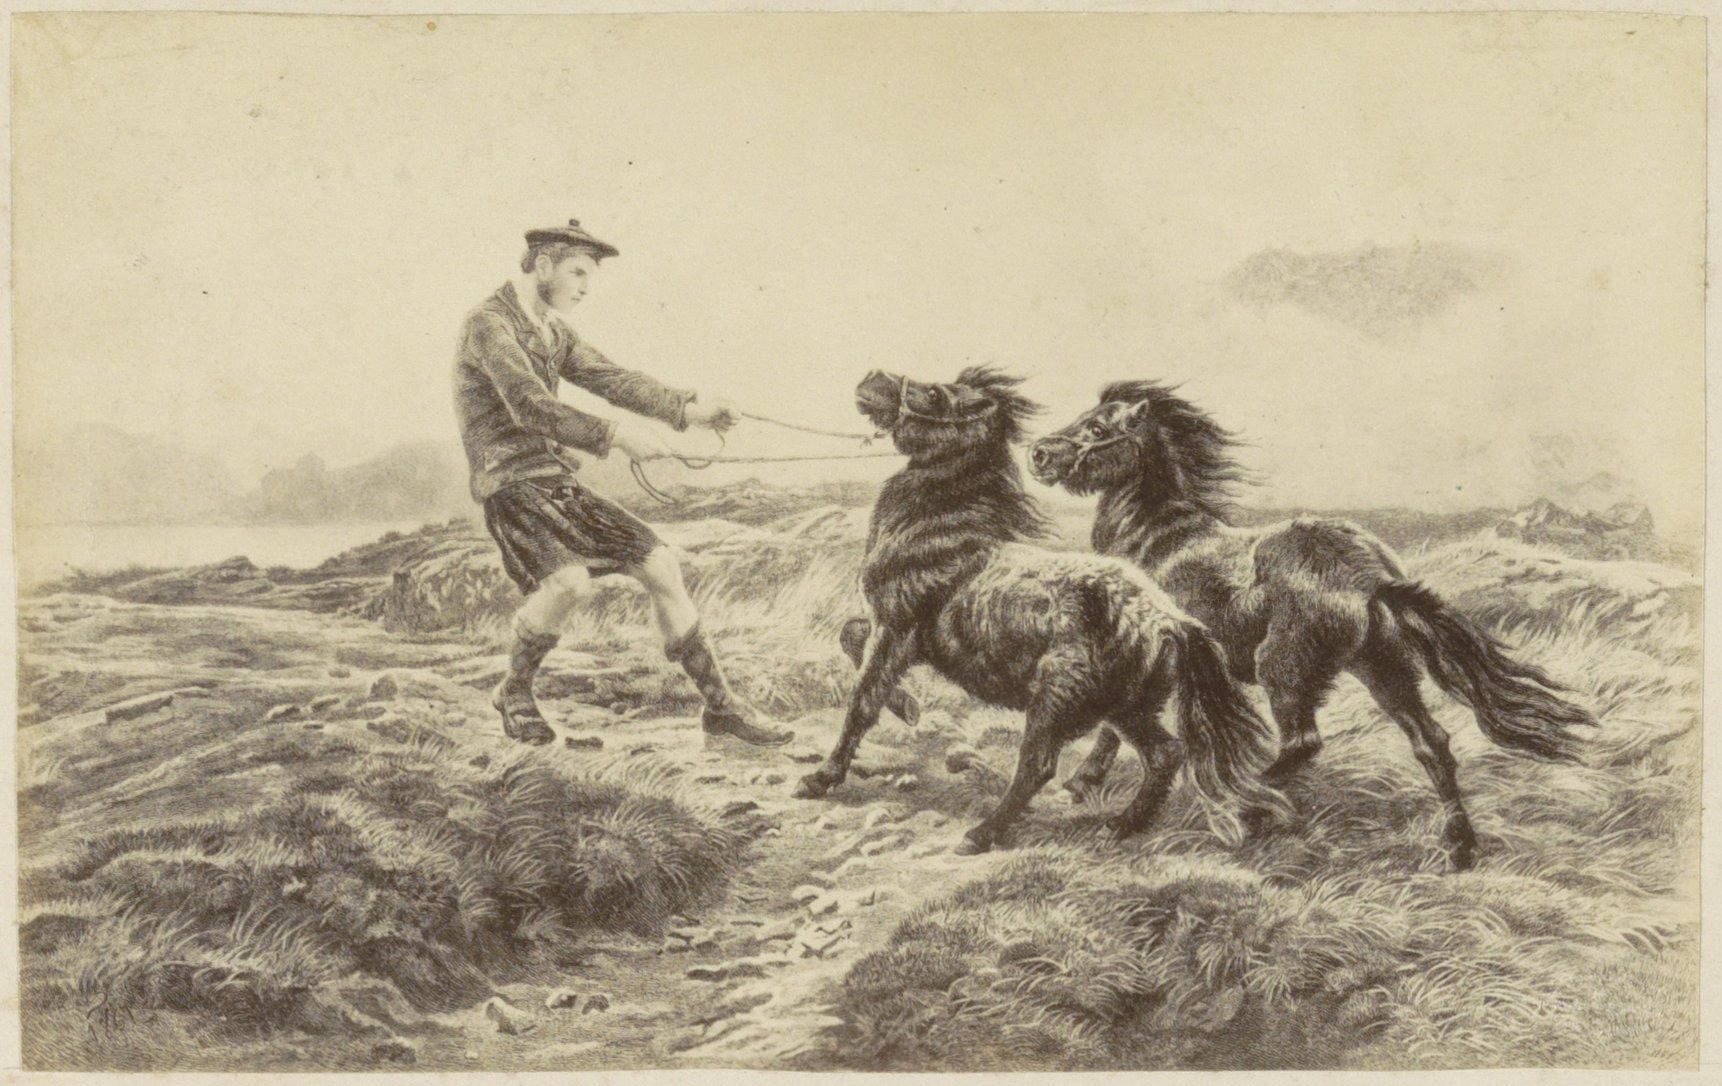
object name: photograph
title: Fotoreproductie van (vermoedelijk) een prent van een Schotse man met twee pony's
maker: Anonymous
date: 1850-1870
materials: paper, photographic support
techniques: albumen print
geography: england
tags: riding a horse, ass, or mule; rider, horseman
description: Onderdeel van Album met foto's van bezienswaardigheden en landschappen in Engeland en van kunst.